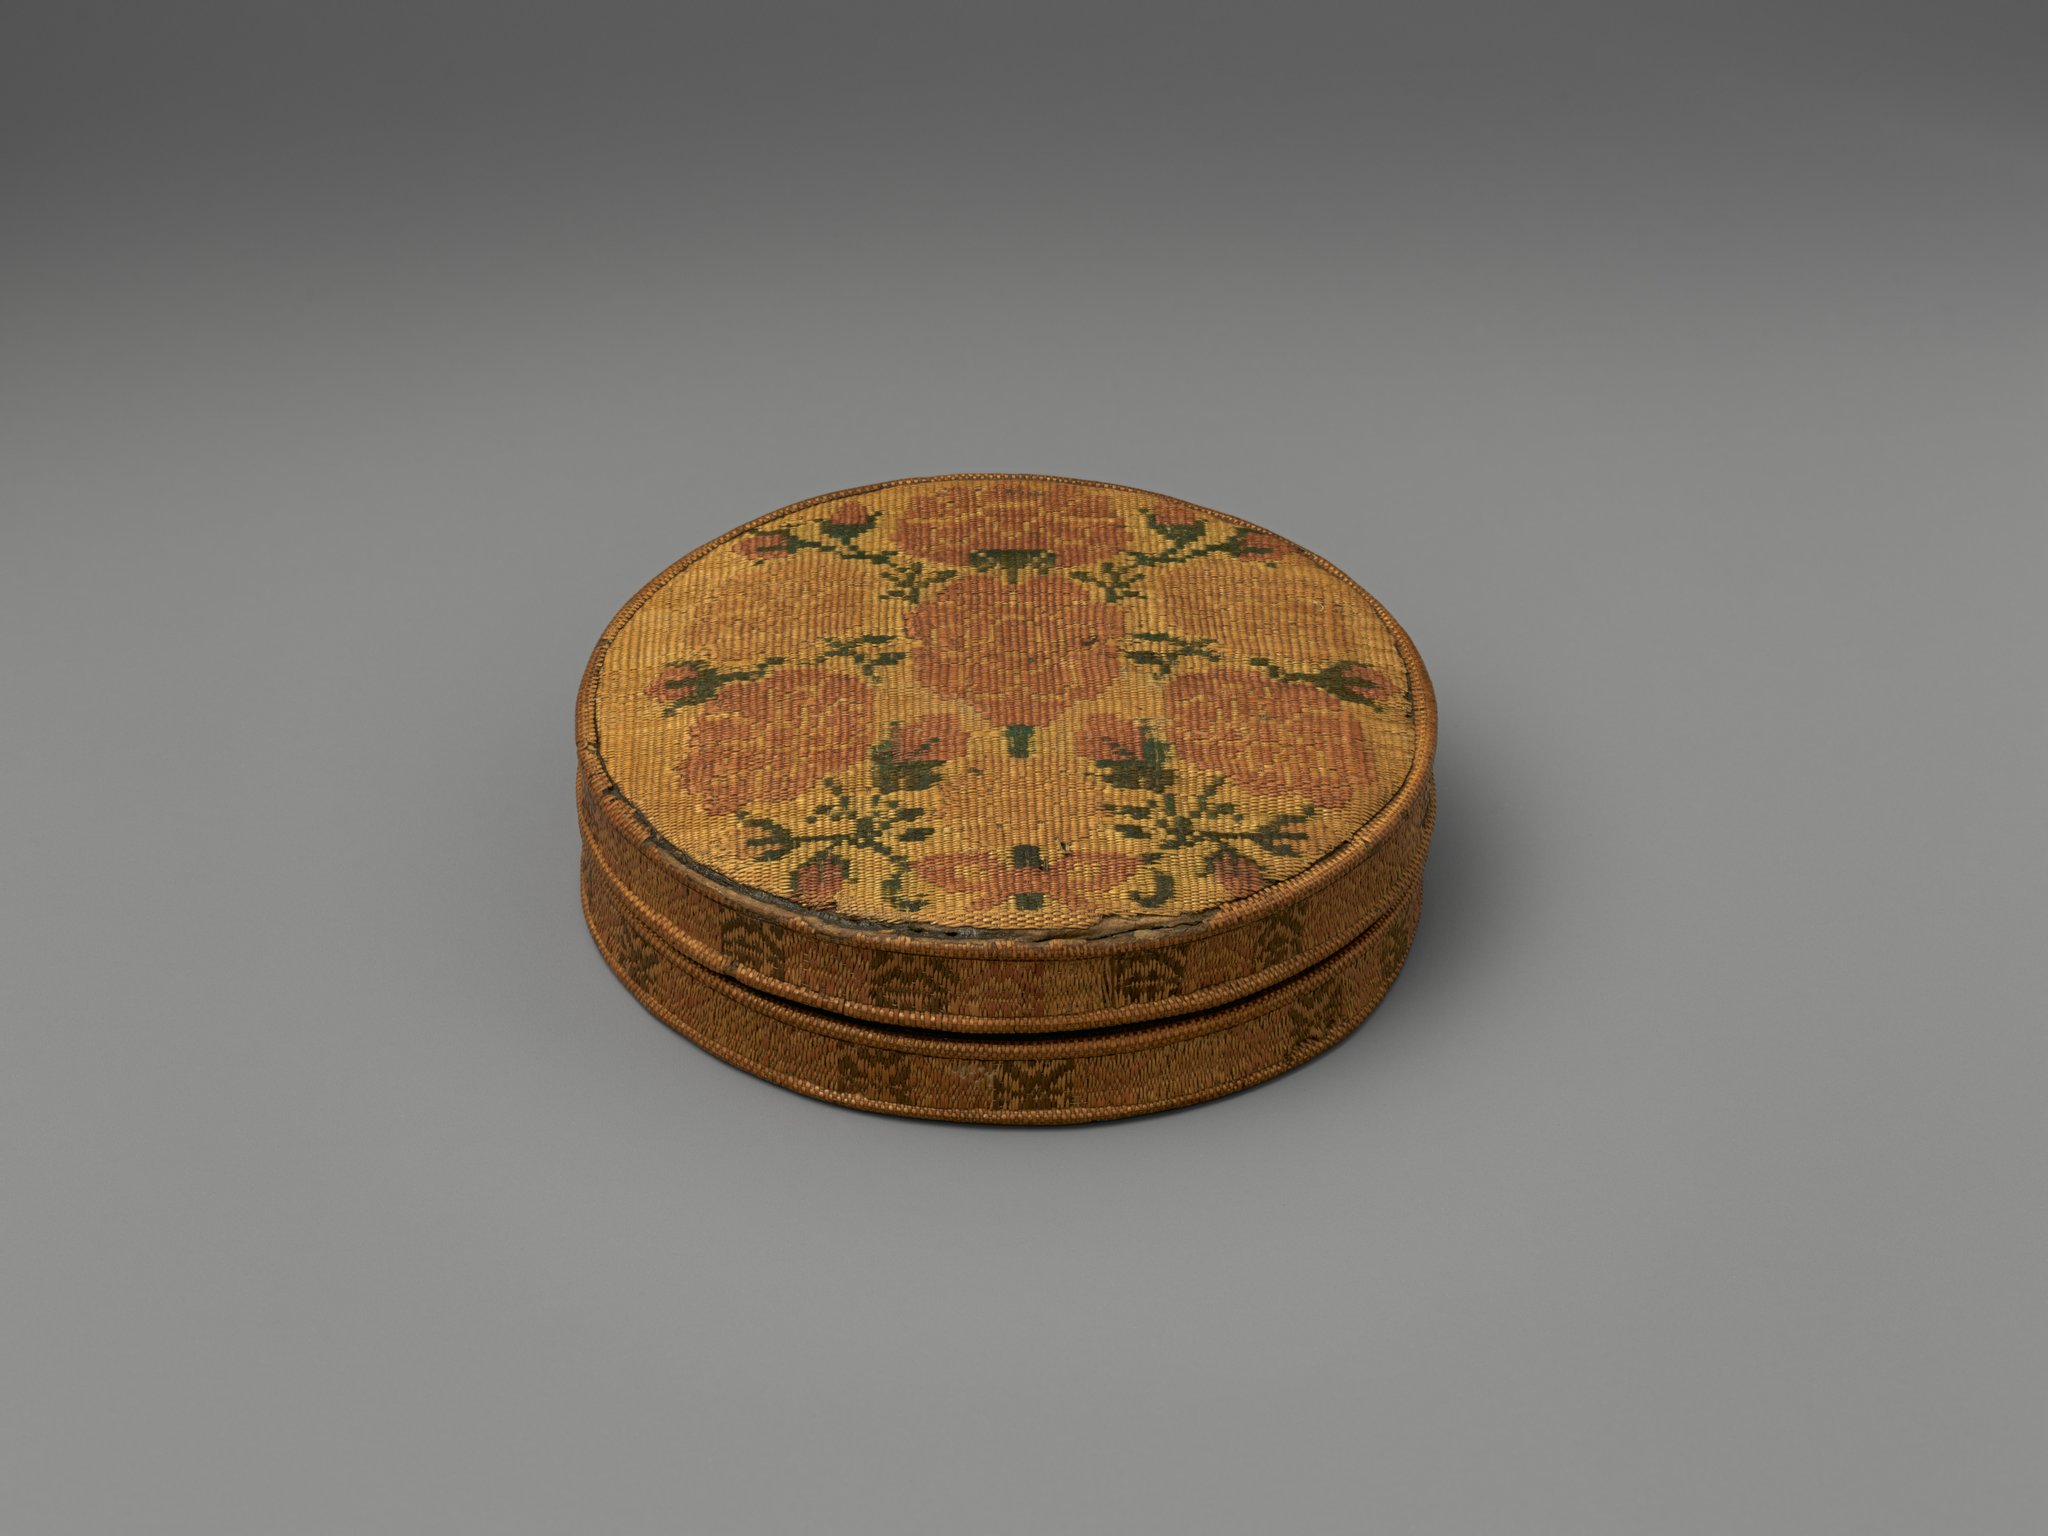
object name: box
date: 1701-1800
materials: fiber, wood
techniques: lining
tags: birds,flowers